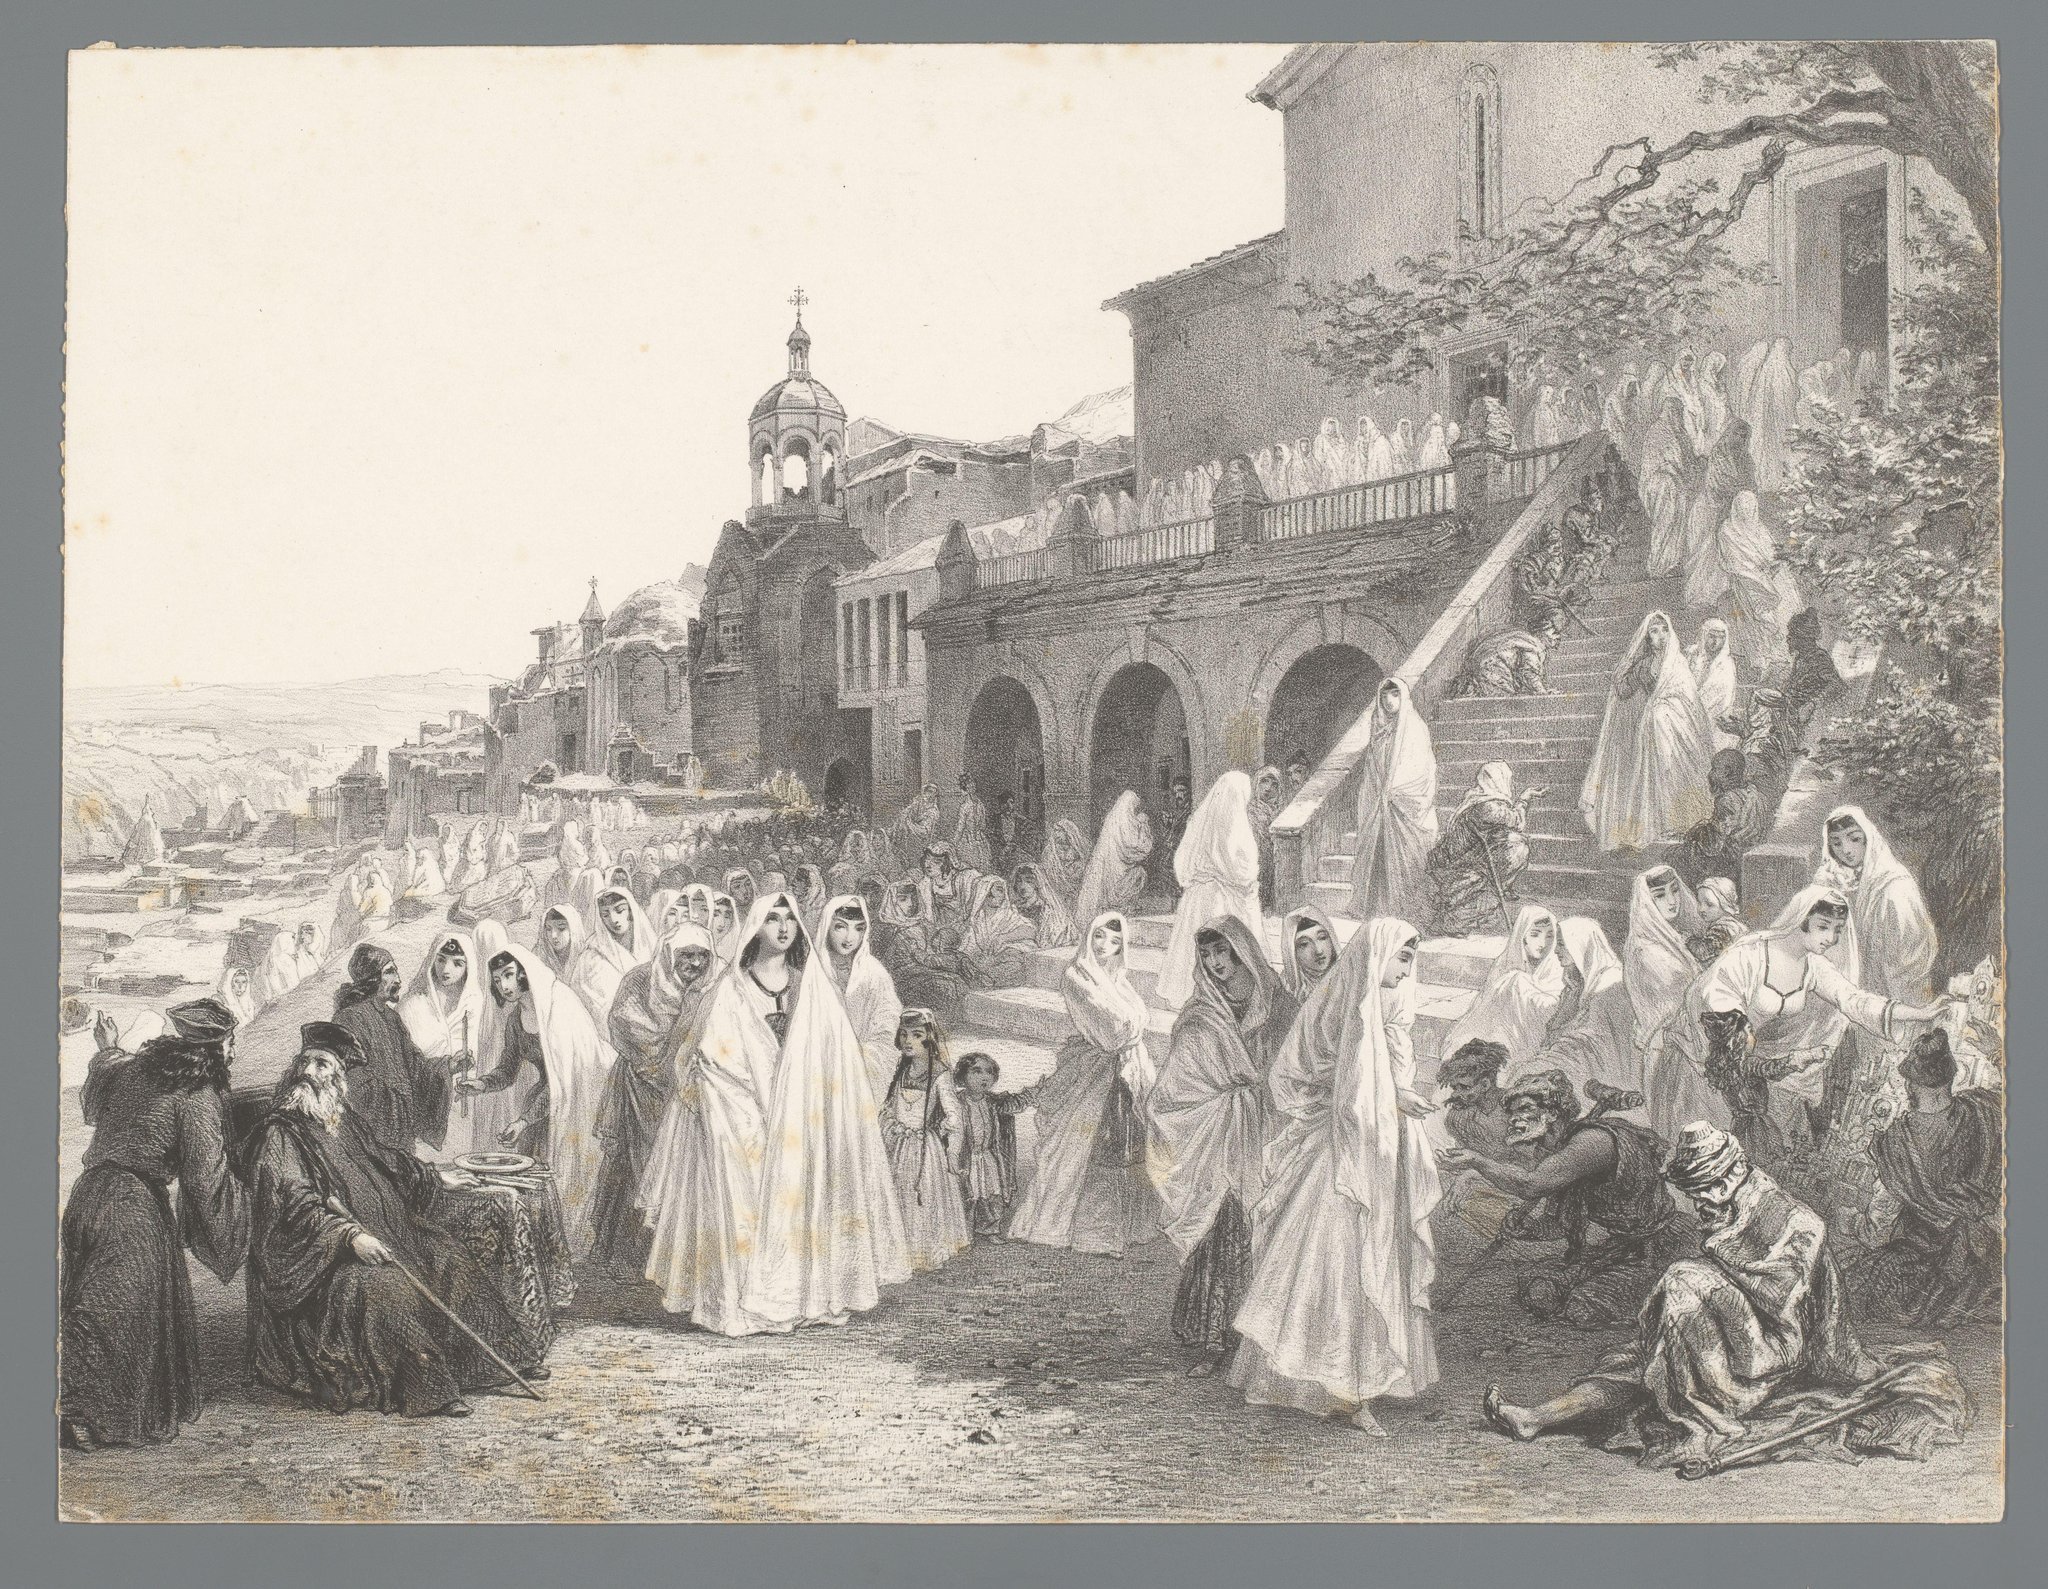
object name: print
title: Vrouwen in witte capes voor ingang van kerkgebouw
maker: adolphe mouilleron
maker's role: draughtsman, print maker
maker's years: 1820-1881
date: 1830-1881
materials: paper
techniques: lithograph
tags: the christian churches, adult woman (+ more than eight persons)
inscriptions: collector's mark: Lugt 964